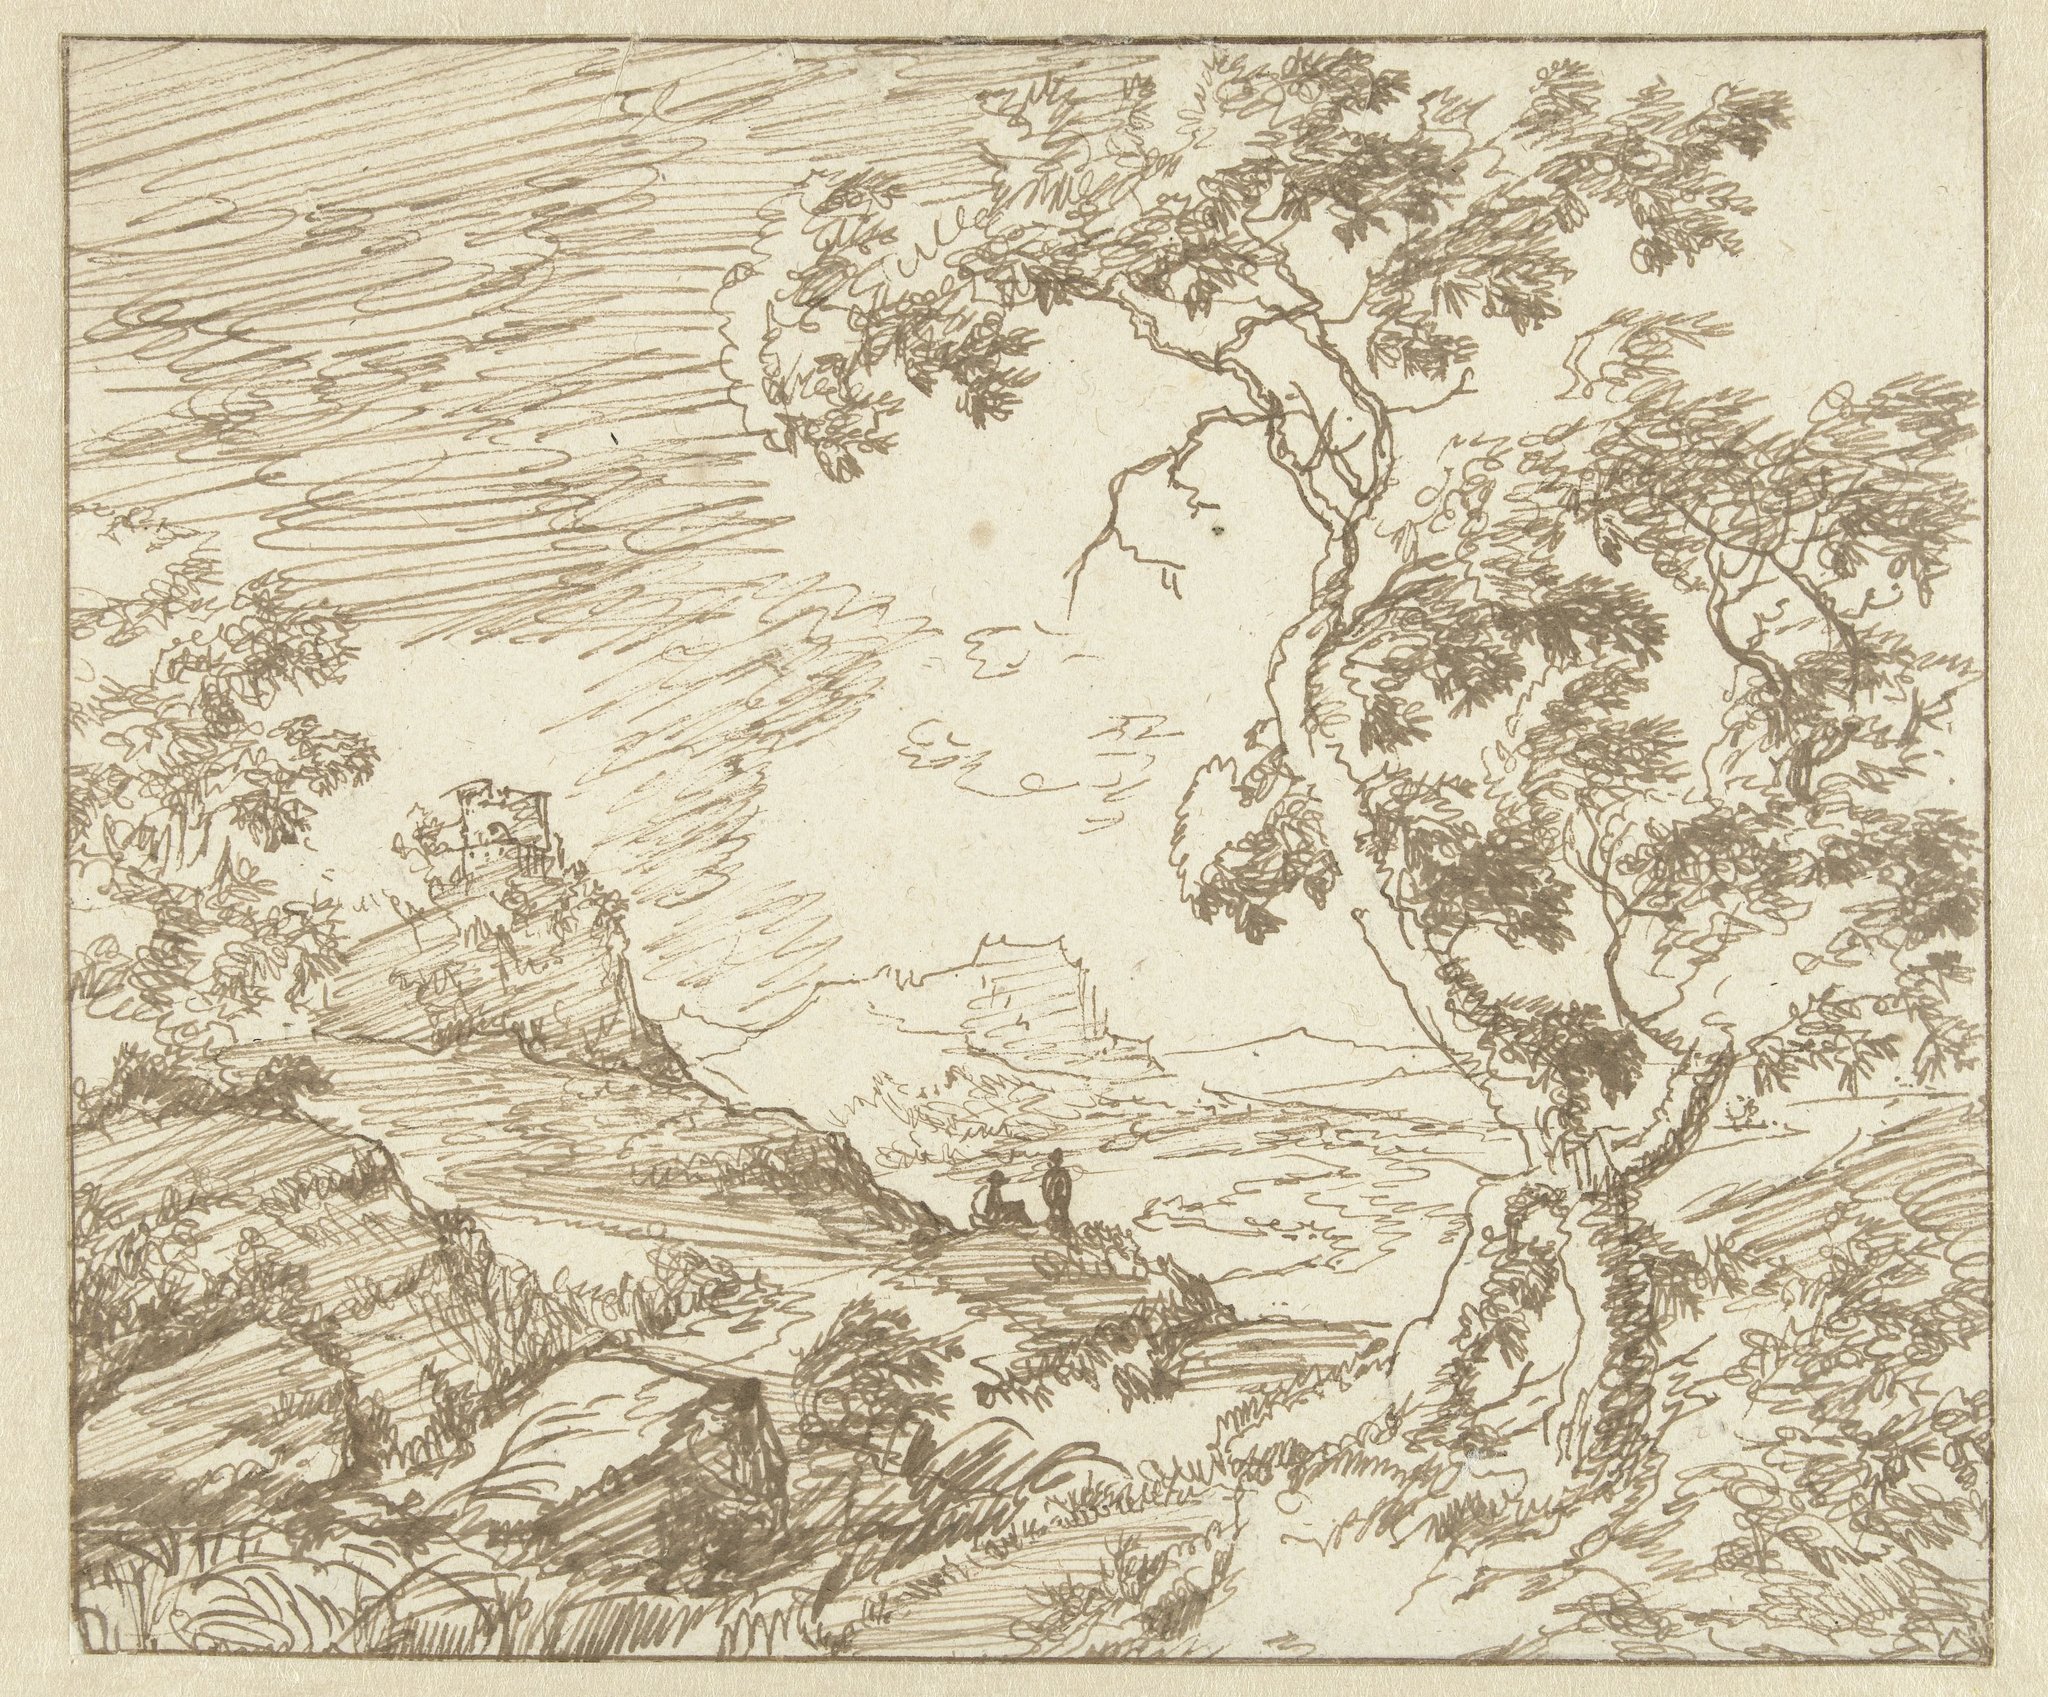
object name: drawing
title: Bergachtig landschap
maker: jan gabrielsz. sonjé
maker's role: draughtsman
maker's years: 1625-1707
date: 1635-1707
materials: ink, paper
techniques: pen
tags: low hill country